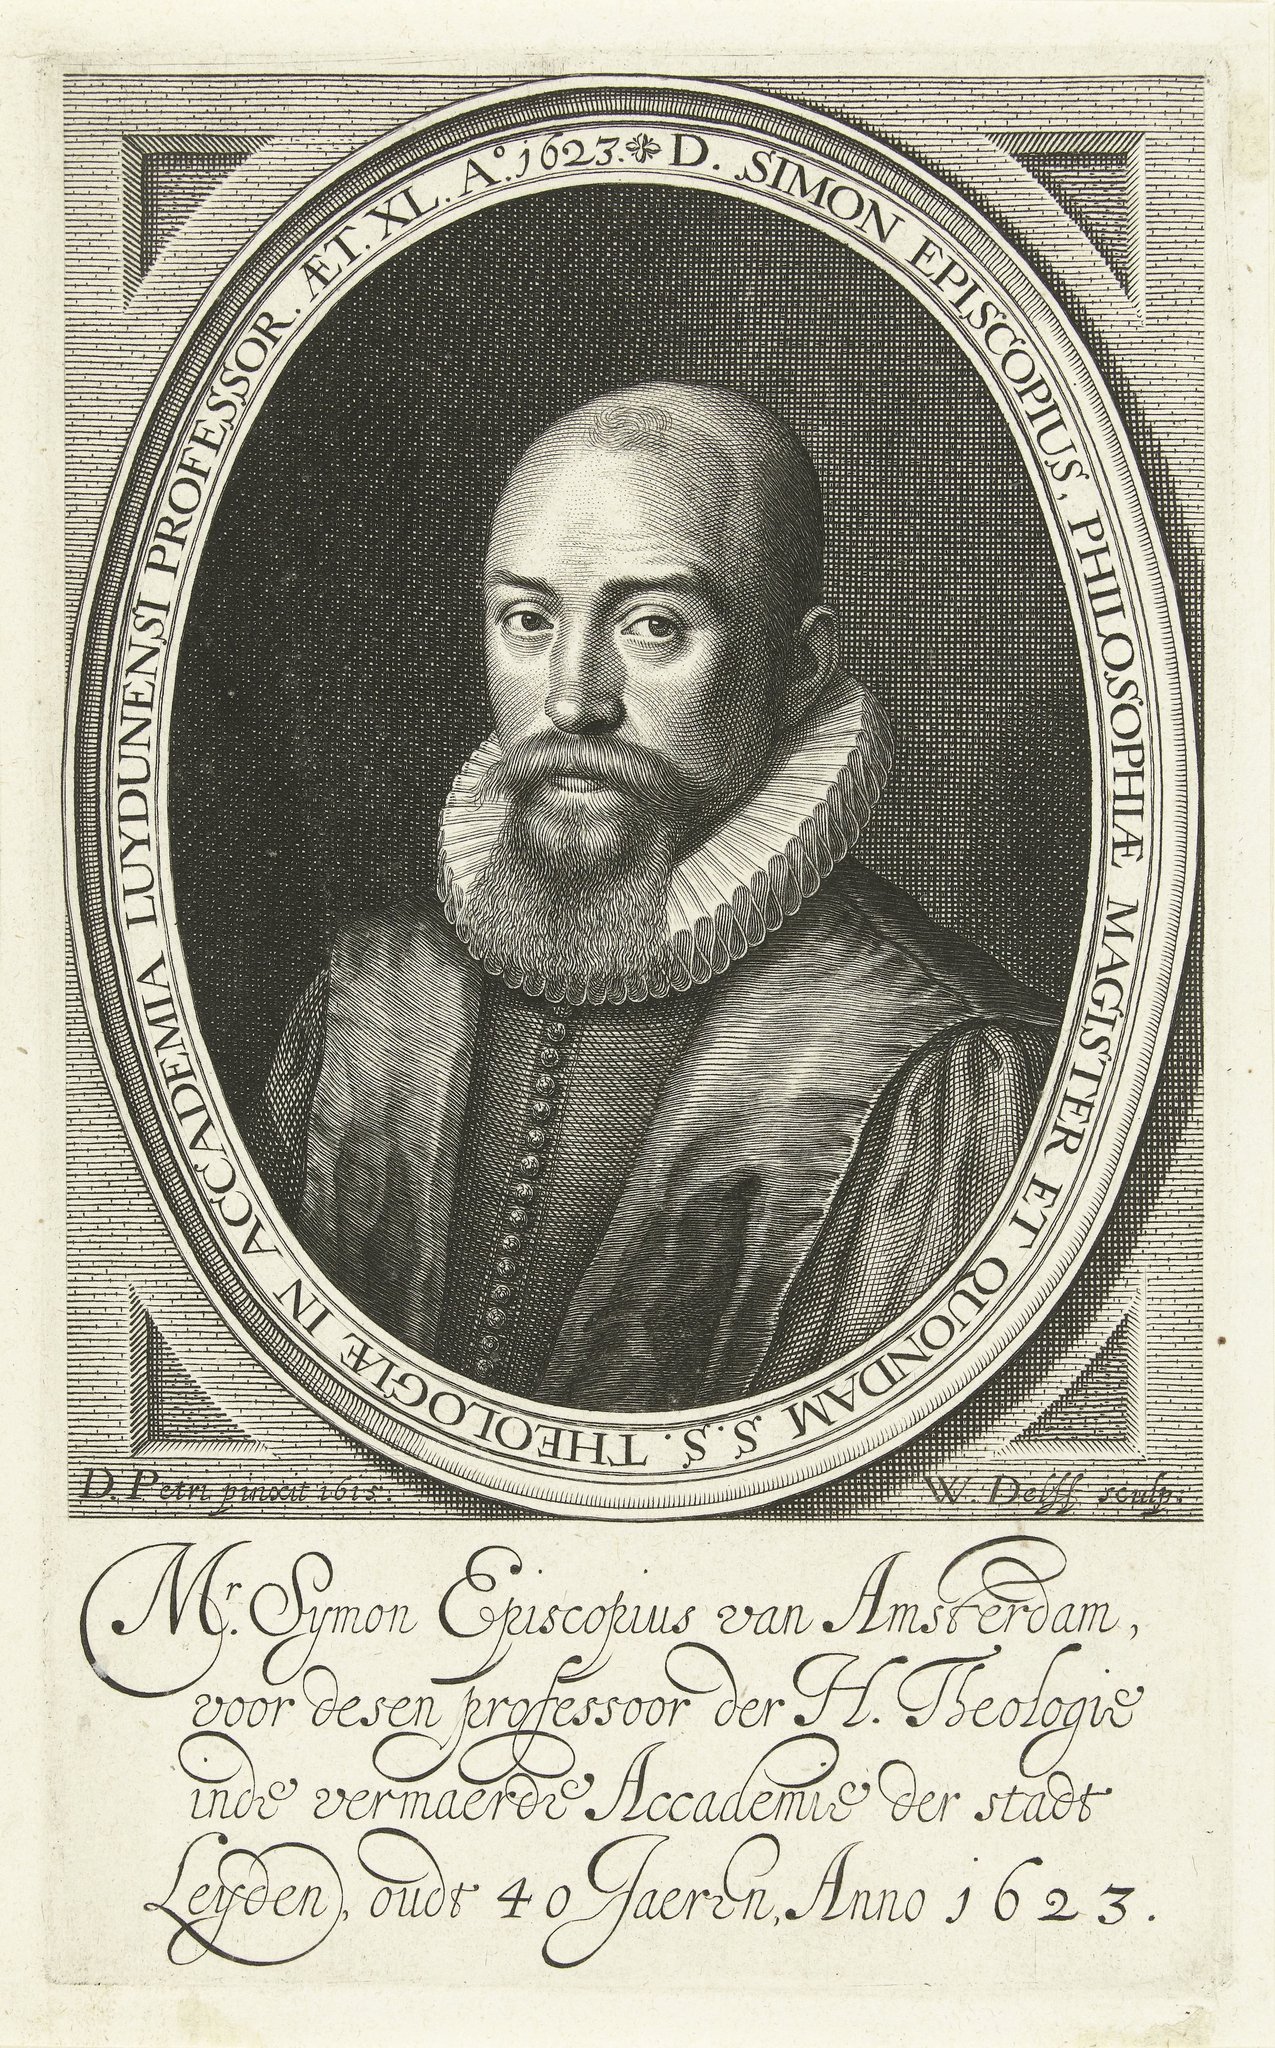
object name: print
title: Portret van Simon Episcopius op 40-jarige leeftijd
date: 1623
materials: paper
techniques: engraving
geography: delft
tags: amsterdam, professor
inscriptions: collector's mark: Lugt 240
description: Portret van Simon Episcopius op 40-jarige leeftijd, borststuk met molenkraag en toga in ovale omlijsting met Latijns opschrift.